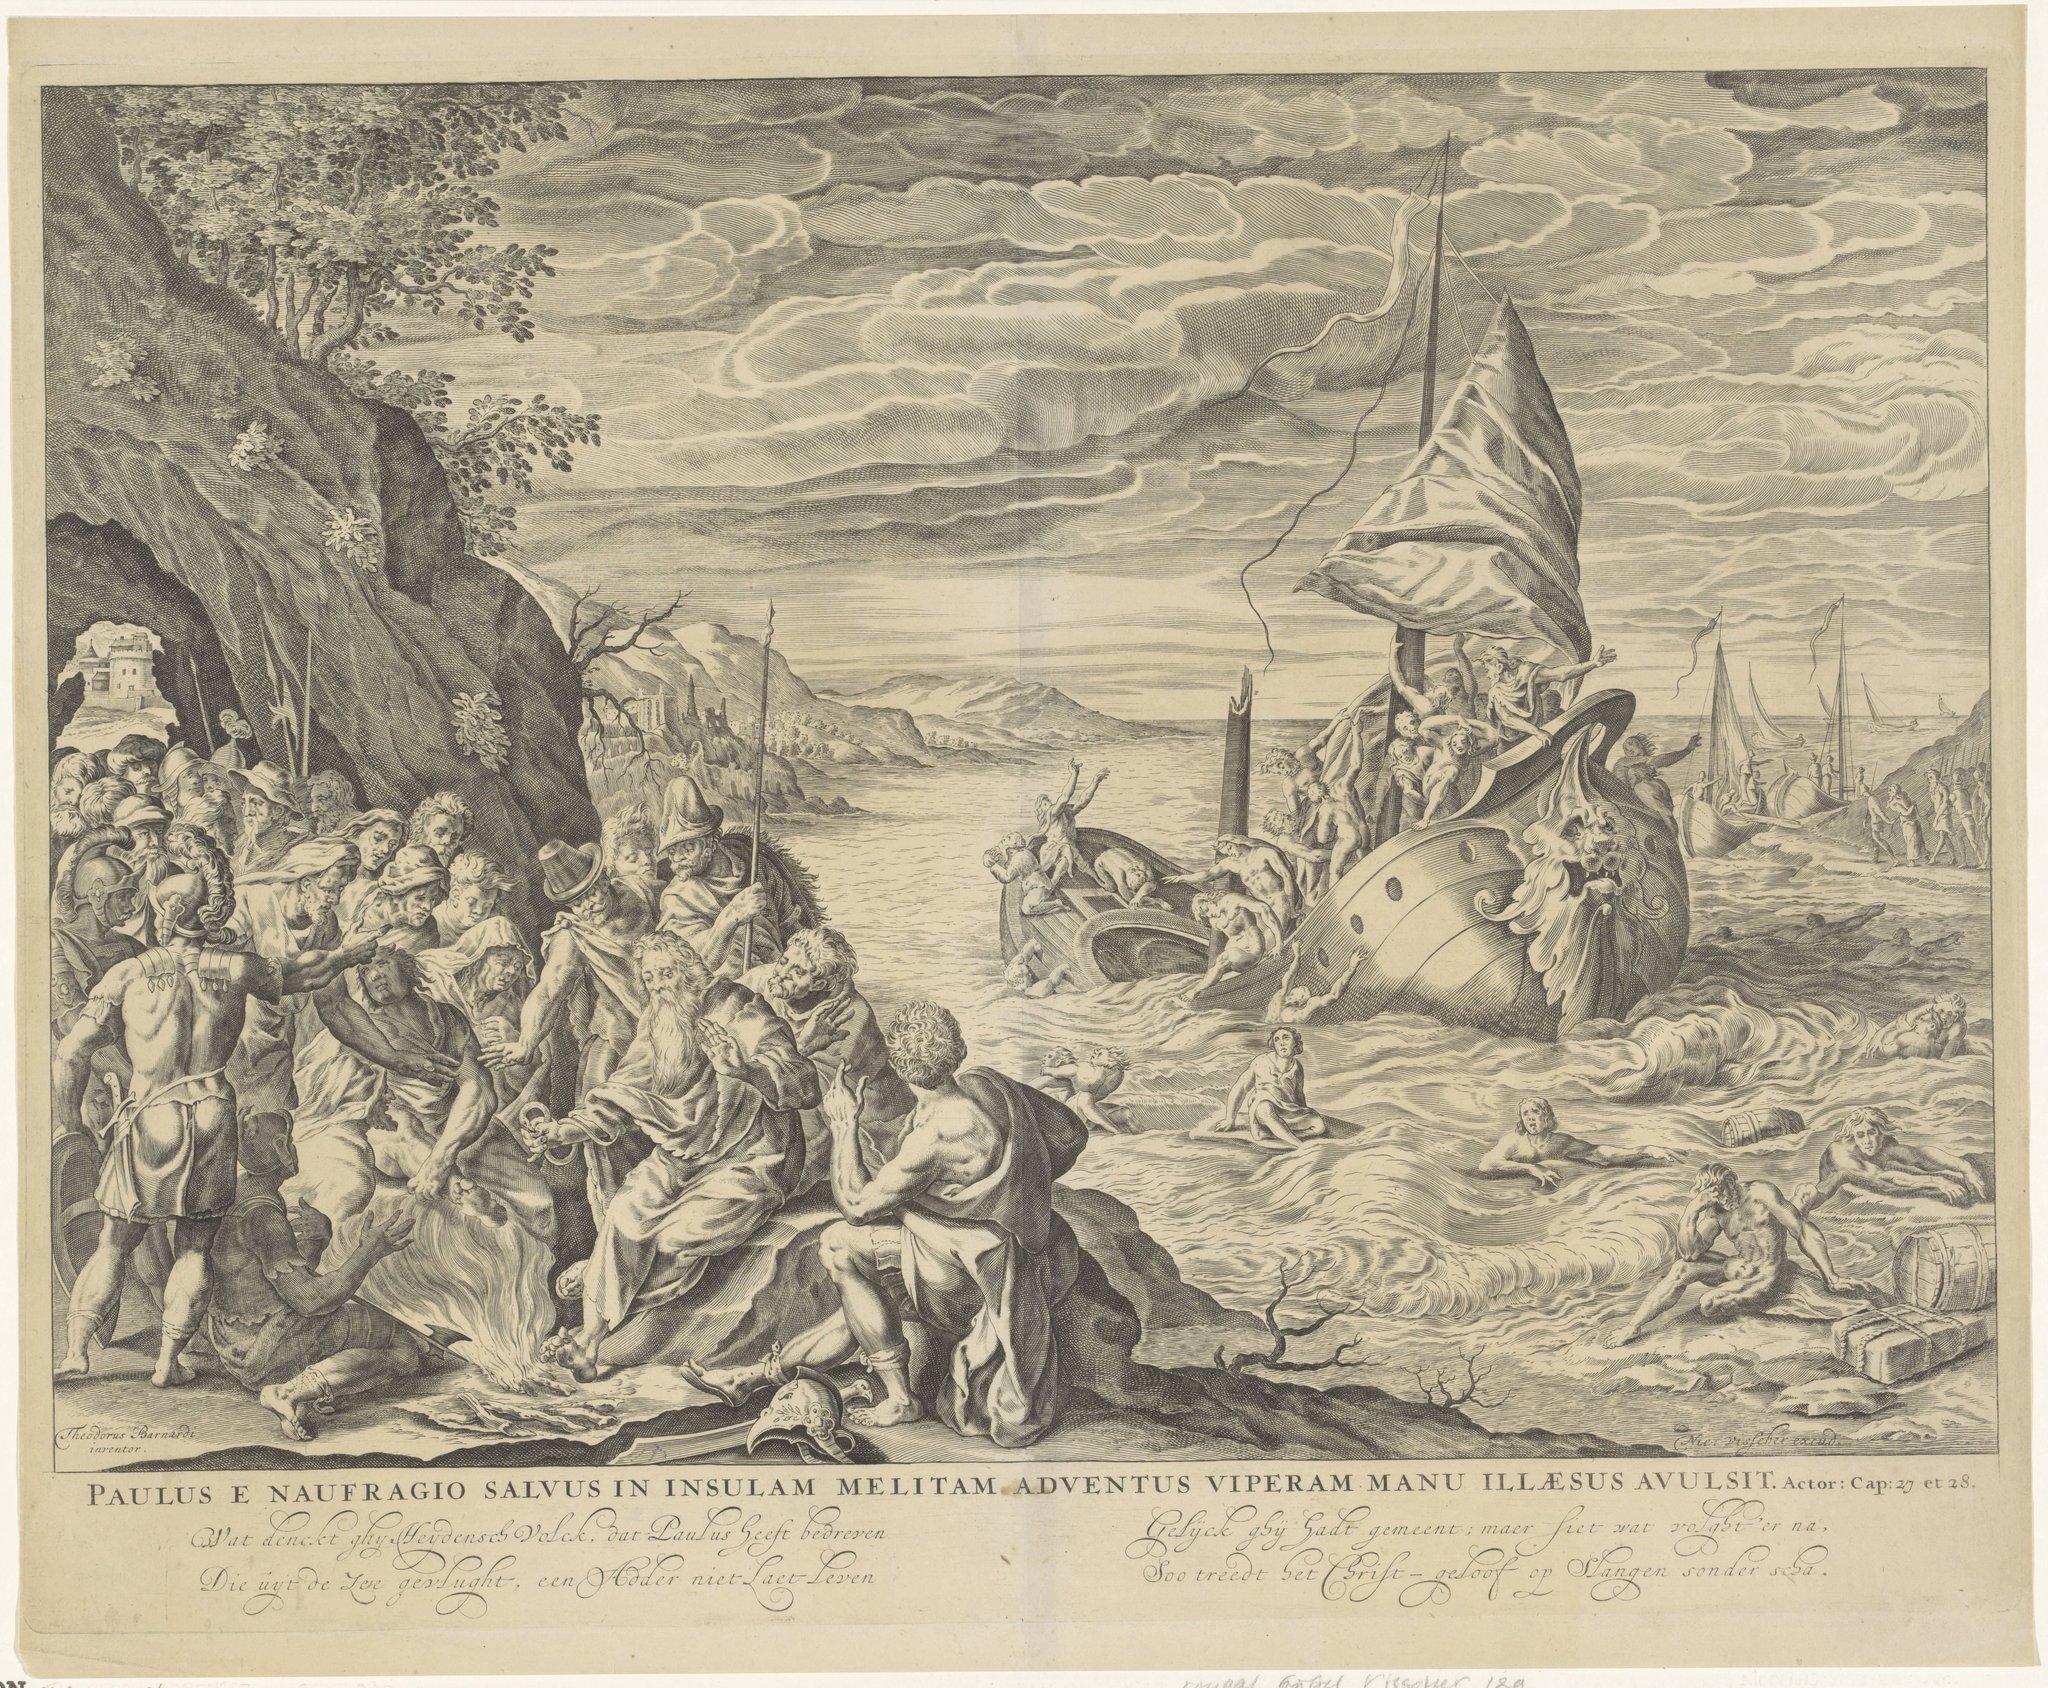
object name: print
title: Paulus e naufragio salvus in insulam Melitam adventus viperam manu illaesus avulsit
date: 1652-1702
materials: paper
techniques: engraving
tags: paul bitten by a viper (when throwing wood on the fire), shipwreck, the shipwreck on the coast of malta (melita) ~ story of paul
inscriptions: collector's mark: Lugt 2228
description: De Amsterdamse uitgever Claes Jansz. Visscher (II) produceerde vanaf de jaren ’30 van de zeventiende eeuw grote Bijbelse prenten op zogenaamd royaal-formaat papier (ca. 480 x 580 mm). Na zijn dood in 1652 zette zijn zoon Nicolaes Visscher (I) het bedrijf voort en zo ook de uitgave van Royaalbijbelprenten. Toen Nicolaes in 1679 overleed nam zijn zoon Nicolaes Visscher (II) het bedrijf over en gaf kort hierna, omstreeks 1680, een fondslijst uit. Hierin worden 130 prenten met Bijbelse voorstellingen op royaalpapier beschreven (zie documentatie J. van der Waals). Complete prentbijbels op royaal-formaat werden door vader en zoon Nicolaes Visscher uitgegeven onder de titel Historiae Sacrae Veteris et Novi Testamenti. De bladen werden echter ook los verkocht en konden worden gecombineerd met Royaalbijbel-prenten van andere uitgevers. Verschillende Amsterdamse uitgevers brachten namelijk ook bijbelprenten op royaal-formaat uit, onder wie Clement de Jonghe en Cornelis Danckerts. De door de firma Visscher uitgegeven prenten zijn veelal vervaardigd door anonieme prentmakers naar voorbeeld van verschillende zestiende- en zeventiende-eeuwse Bijbelse prenten en prentreeksen. Veelal moesten de composities worden aangepast aan het grotere en langgerekte royaal-formaat. Daarnaast zijn er ook grote bladen van bekende prentmakers zoals Jan van Londerseel, Pieter Nolpe, Jacques de Gheyn (II) en Jan Harmensz. Muller opgenomen in de categorie ‘Bybelsche Figuren, op Royaal-bladen’ in de fondslijst van Visscher. Prent mogelijk gebruikt in: Historiae Sacrae Veteris et Novi Testamenti (Royaalbijbel). Amsterdam: Nicolaes Visscher (I) en (II), [1652-1702]. In de fondslijst van Nicolaes Visscher II (ca. 1680) is het onderwerp van deze prent onder de titel 'Bybelsche Figuren, op Royaal-bladen. bestaande uyt de volgende historien.' als volgt genummerd: 129. De hoofdvoorstelling naar een prent van Harmen Jansz Muller naar ontwerp van Dirck Barendsz.. De groep van twee soldaten en de zittende man links naar een prent van Johann Sadeler (I) naar ontwerp van Maarten de Vos.